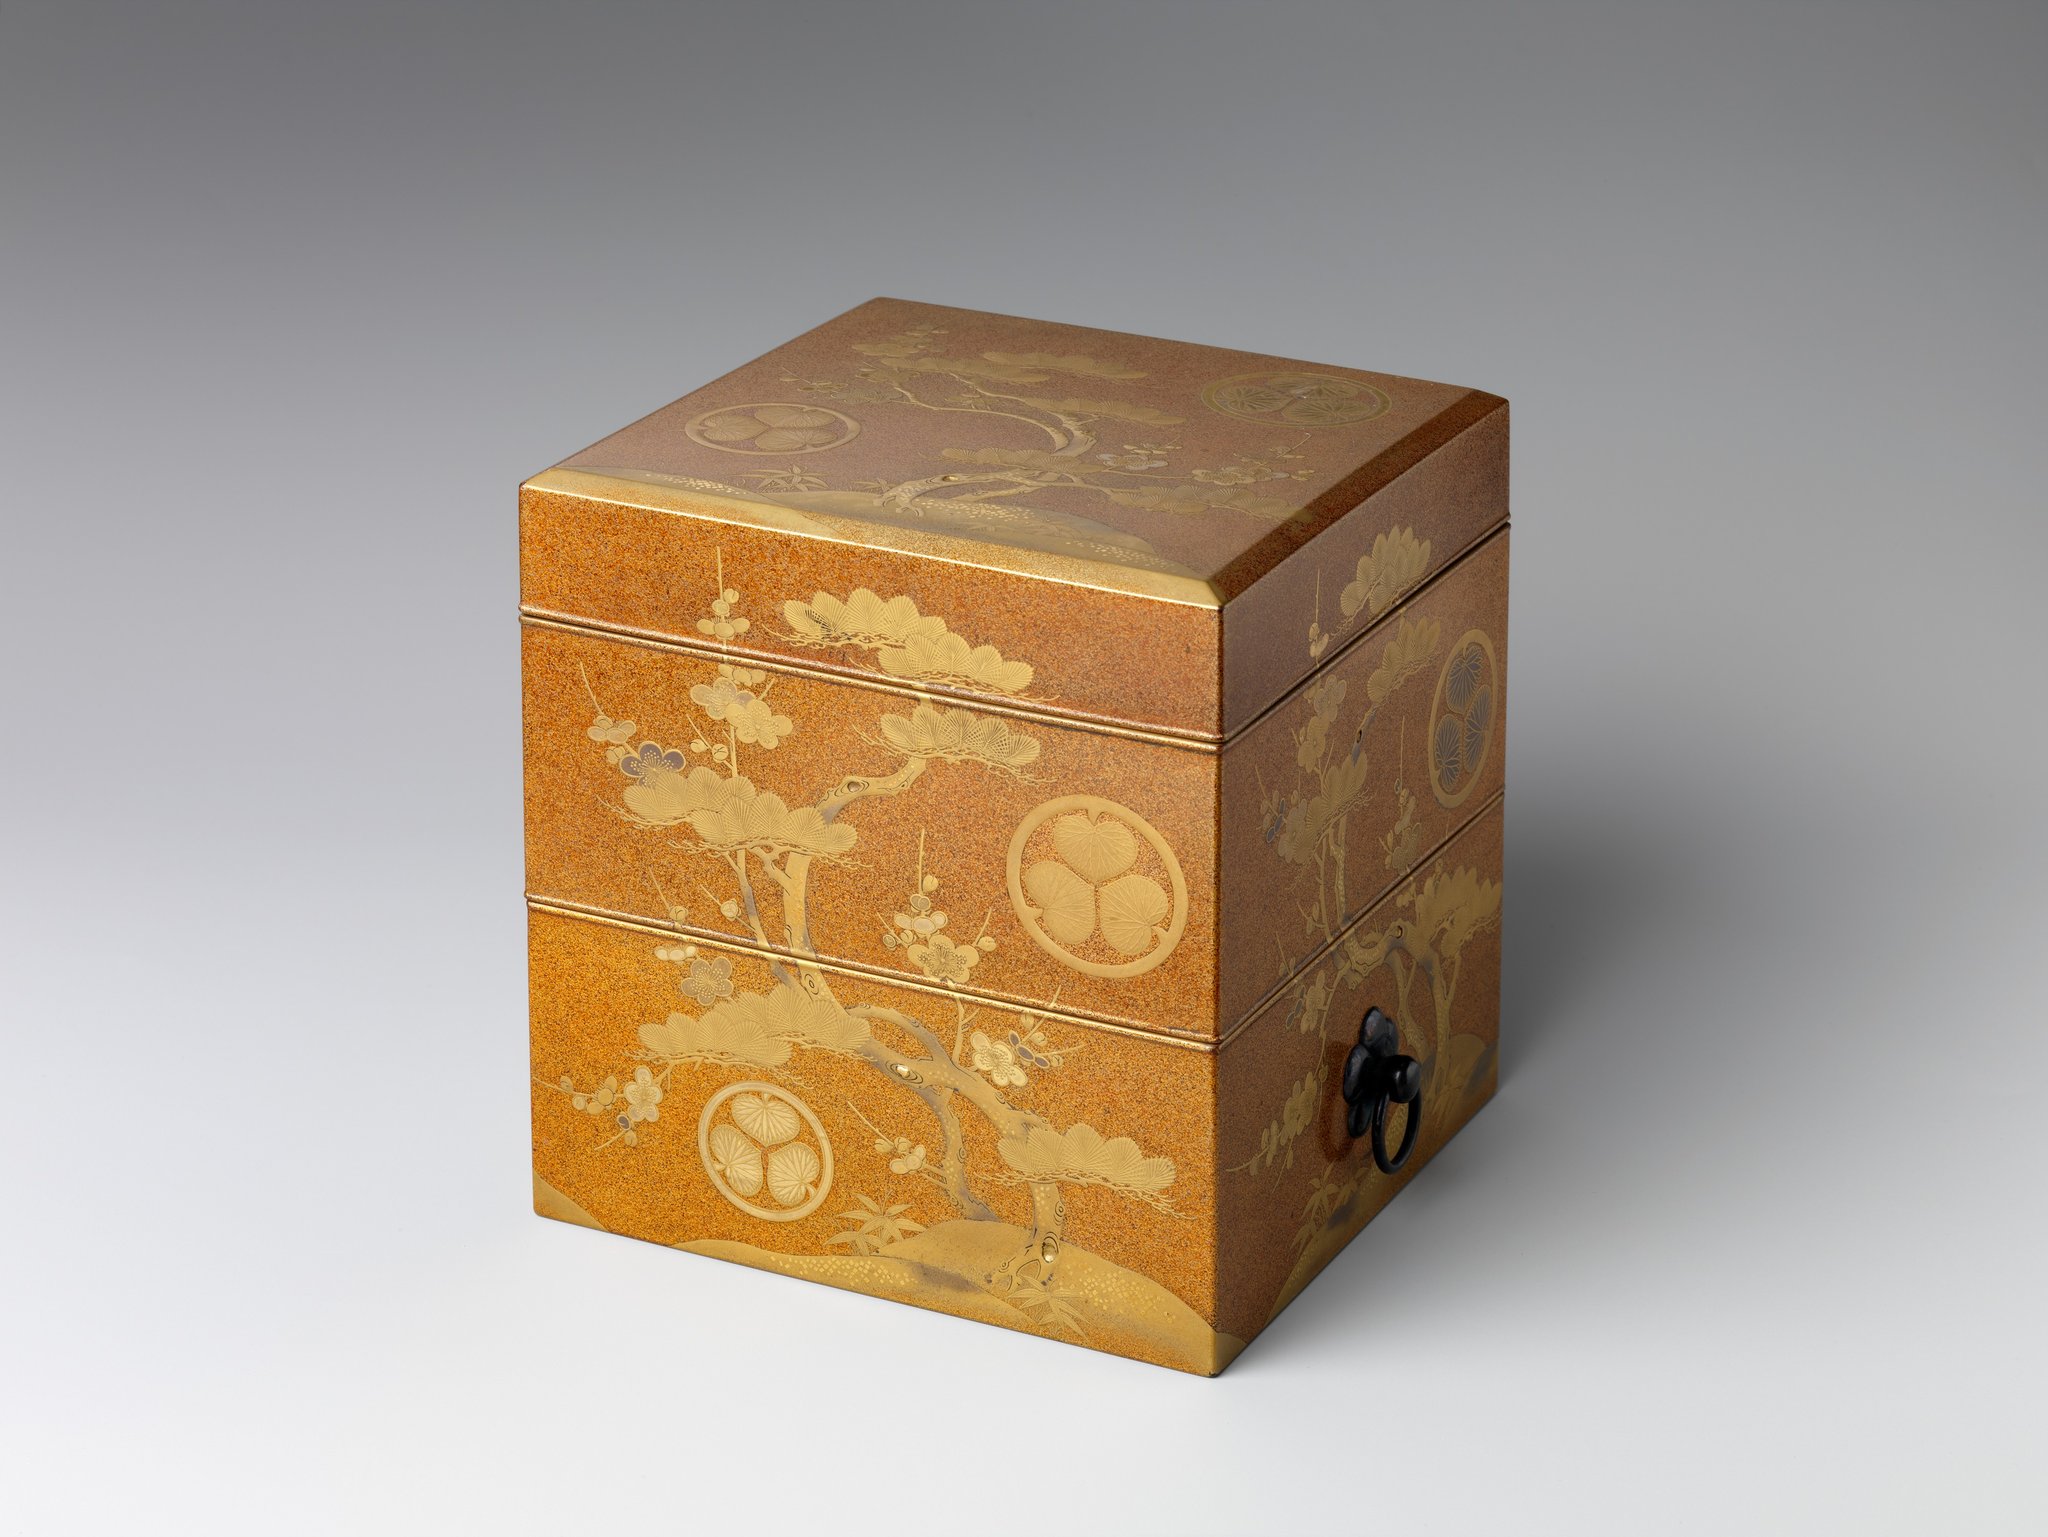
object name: box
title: Box from a Marriage Set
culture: japanese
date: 1701-1750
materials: lacquer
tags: flowers,trees